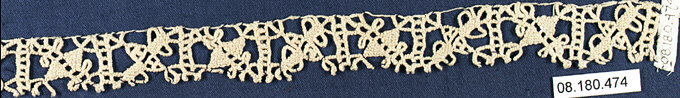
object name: border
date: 1601-1700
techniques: lace